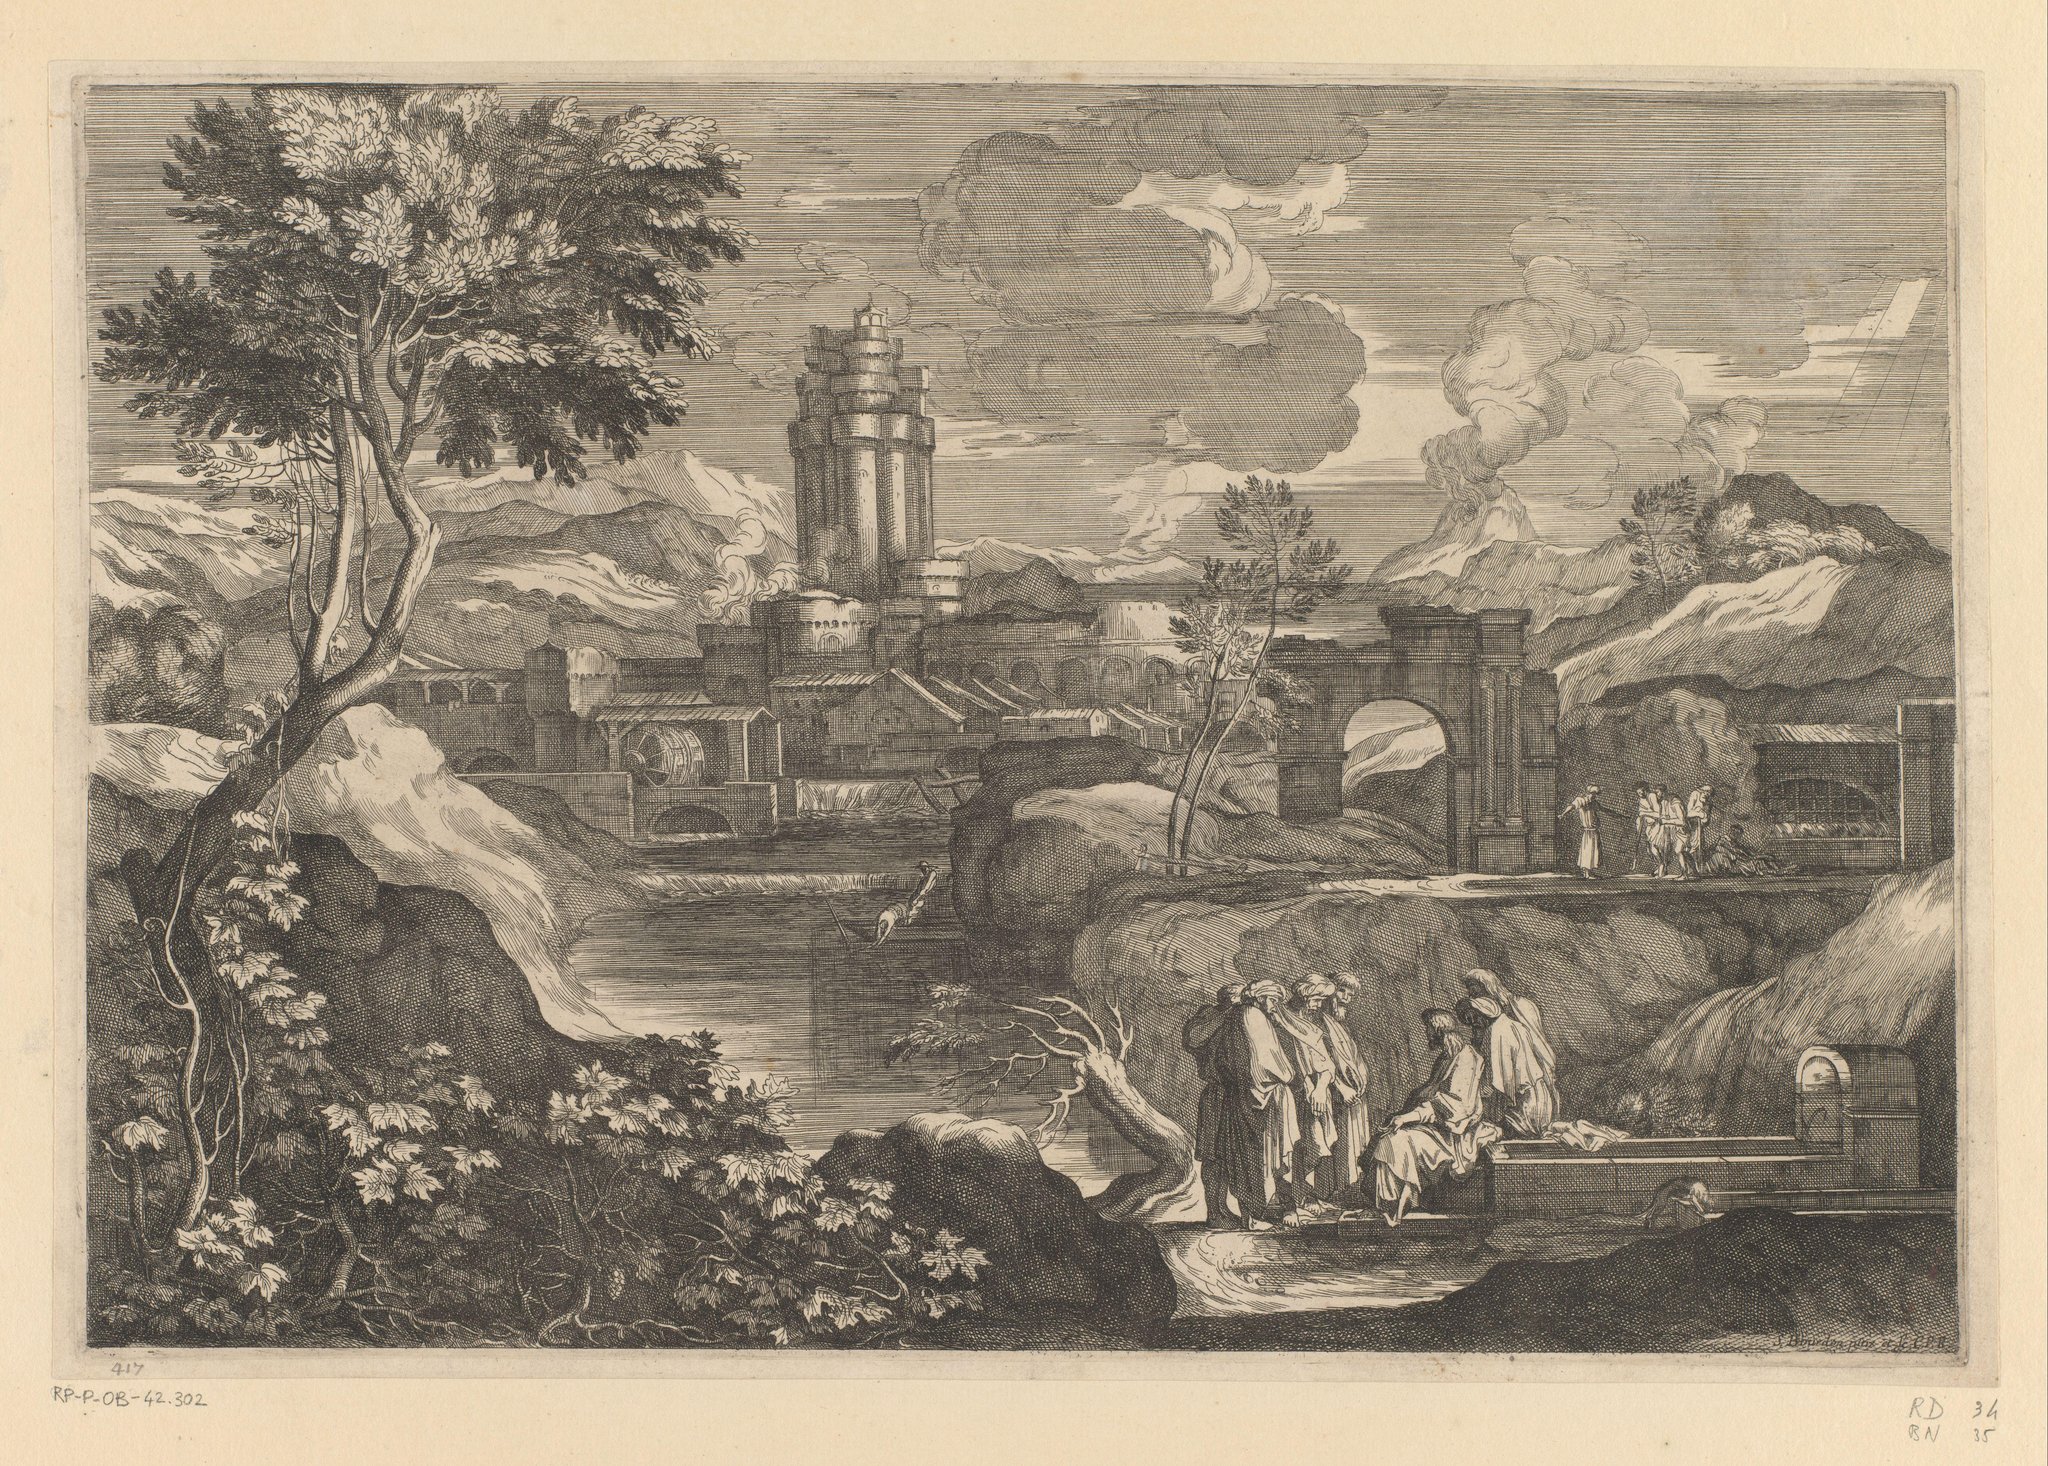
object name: print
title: Landschappen met Bijbelse taferelen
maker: sébastien bourdon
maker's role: draughtsman, painter, print maker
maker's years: 1616-1671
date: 1626-1671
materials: paper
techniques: etching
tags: landscapes, genesis: the story of joseph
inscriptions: collector's mark: Lugt 240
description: Maakt deel uit van een serie van twaalf prenten van landschappen met enkele Bijbelse taferelen.